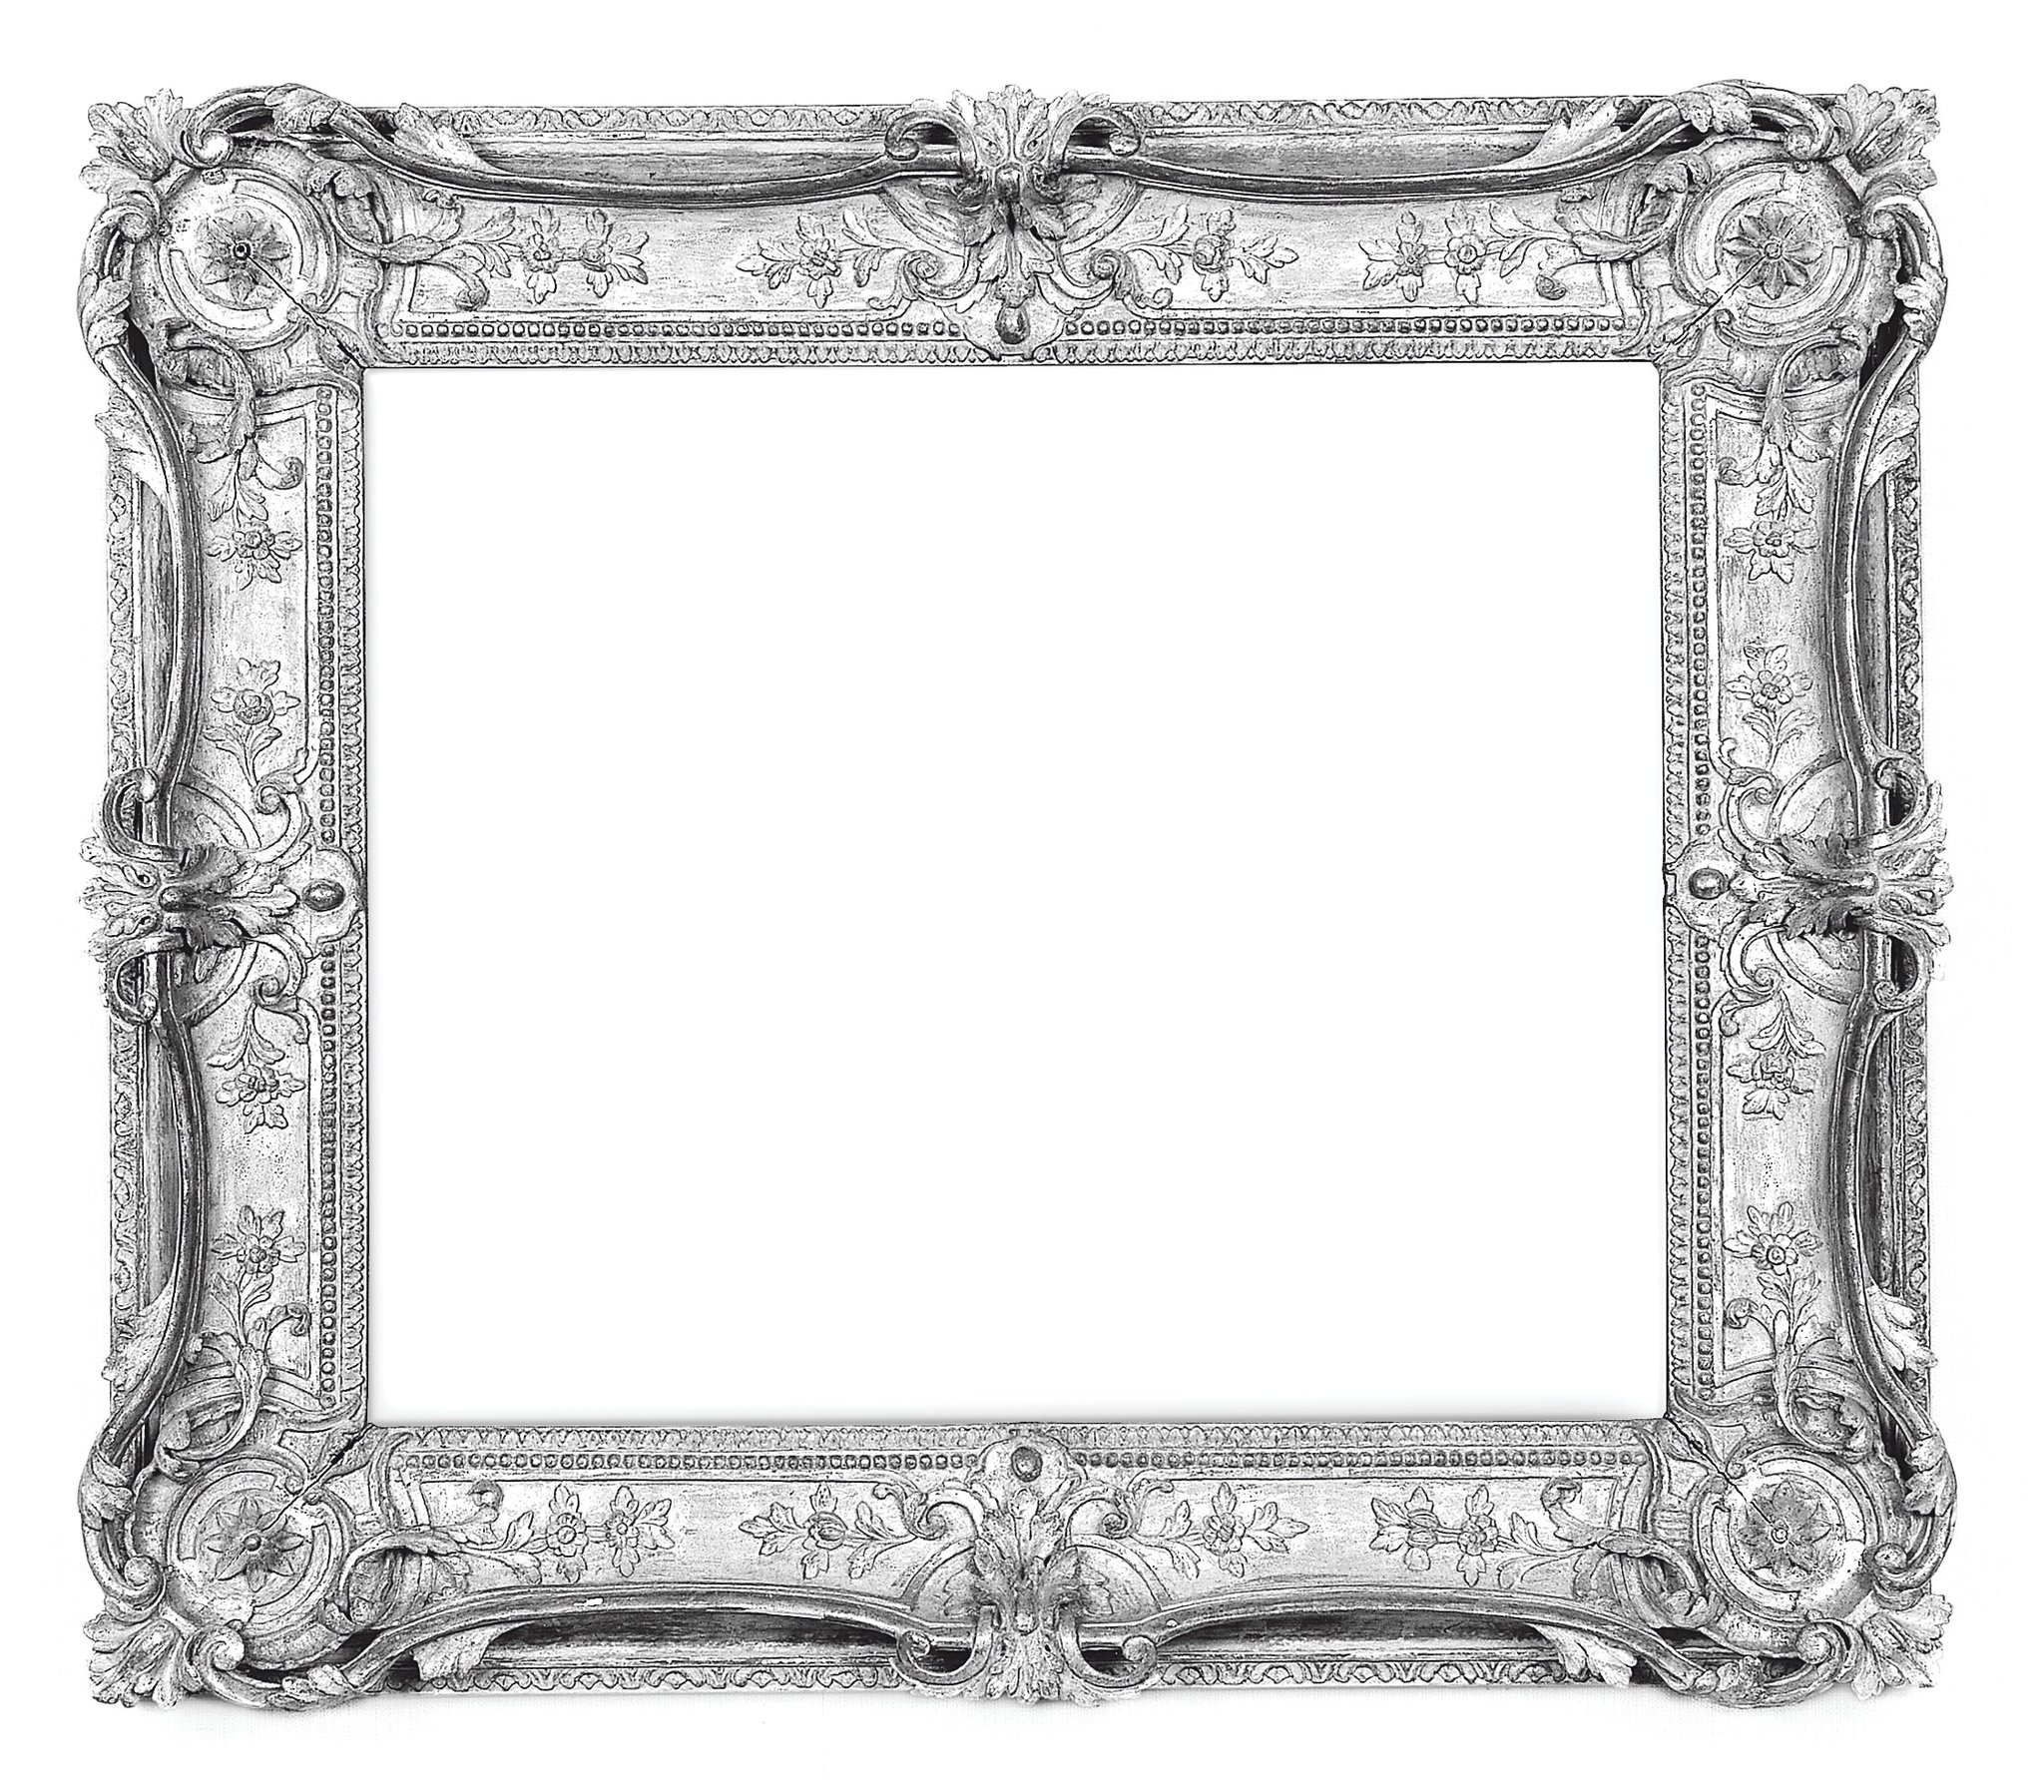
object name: frame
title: Swept frame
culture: french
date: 1750-1760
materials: wood